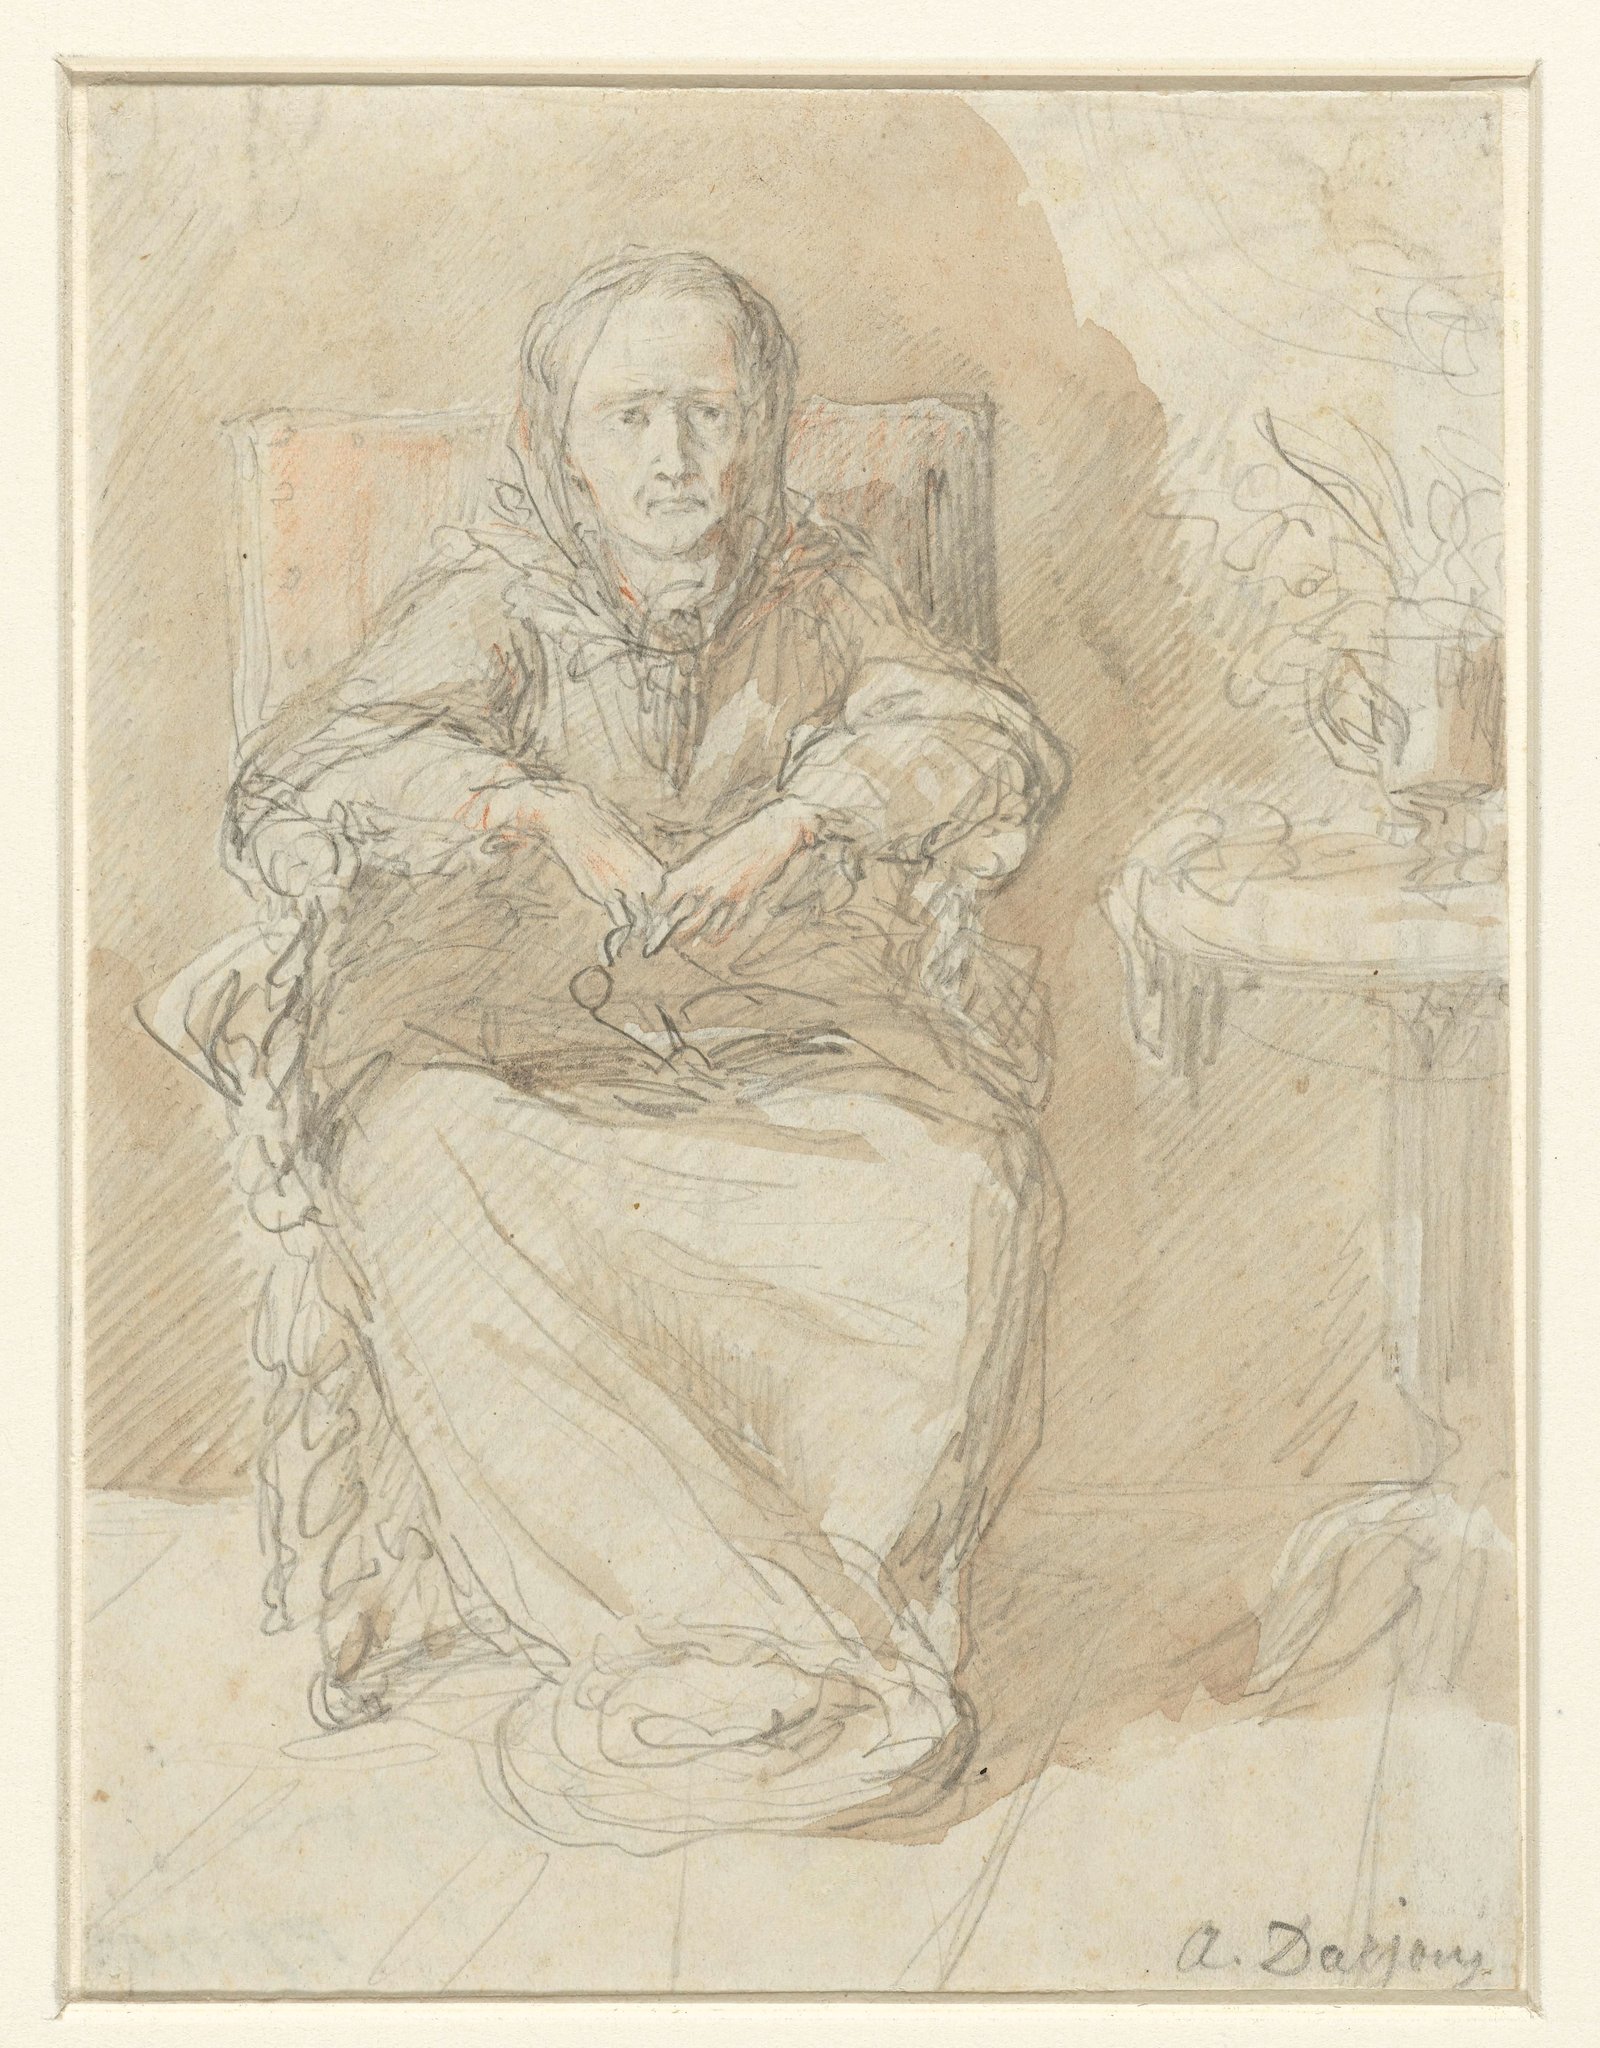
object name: drawing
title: Zittende oude dame naast een tafel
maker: alfred darjou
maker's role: draughtsman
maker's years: 1832-1874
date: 1842-1874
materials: chalk, paper, pencil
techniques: brush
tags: sitting figure - aa - female human figure, old woman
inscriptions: signature, recto, lower right, pencil: ‘a. Darjou’, annotation, verso, lower right, pencil: ‘Darjou / P.J. 1163’, collector's mark, verso, on the passepartout: Lugt 2228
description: Zittende oude dame, met naast zich een tafel waarop een bloemvaas.